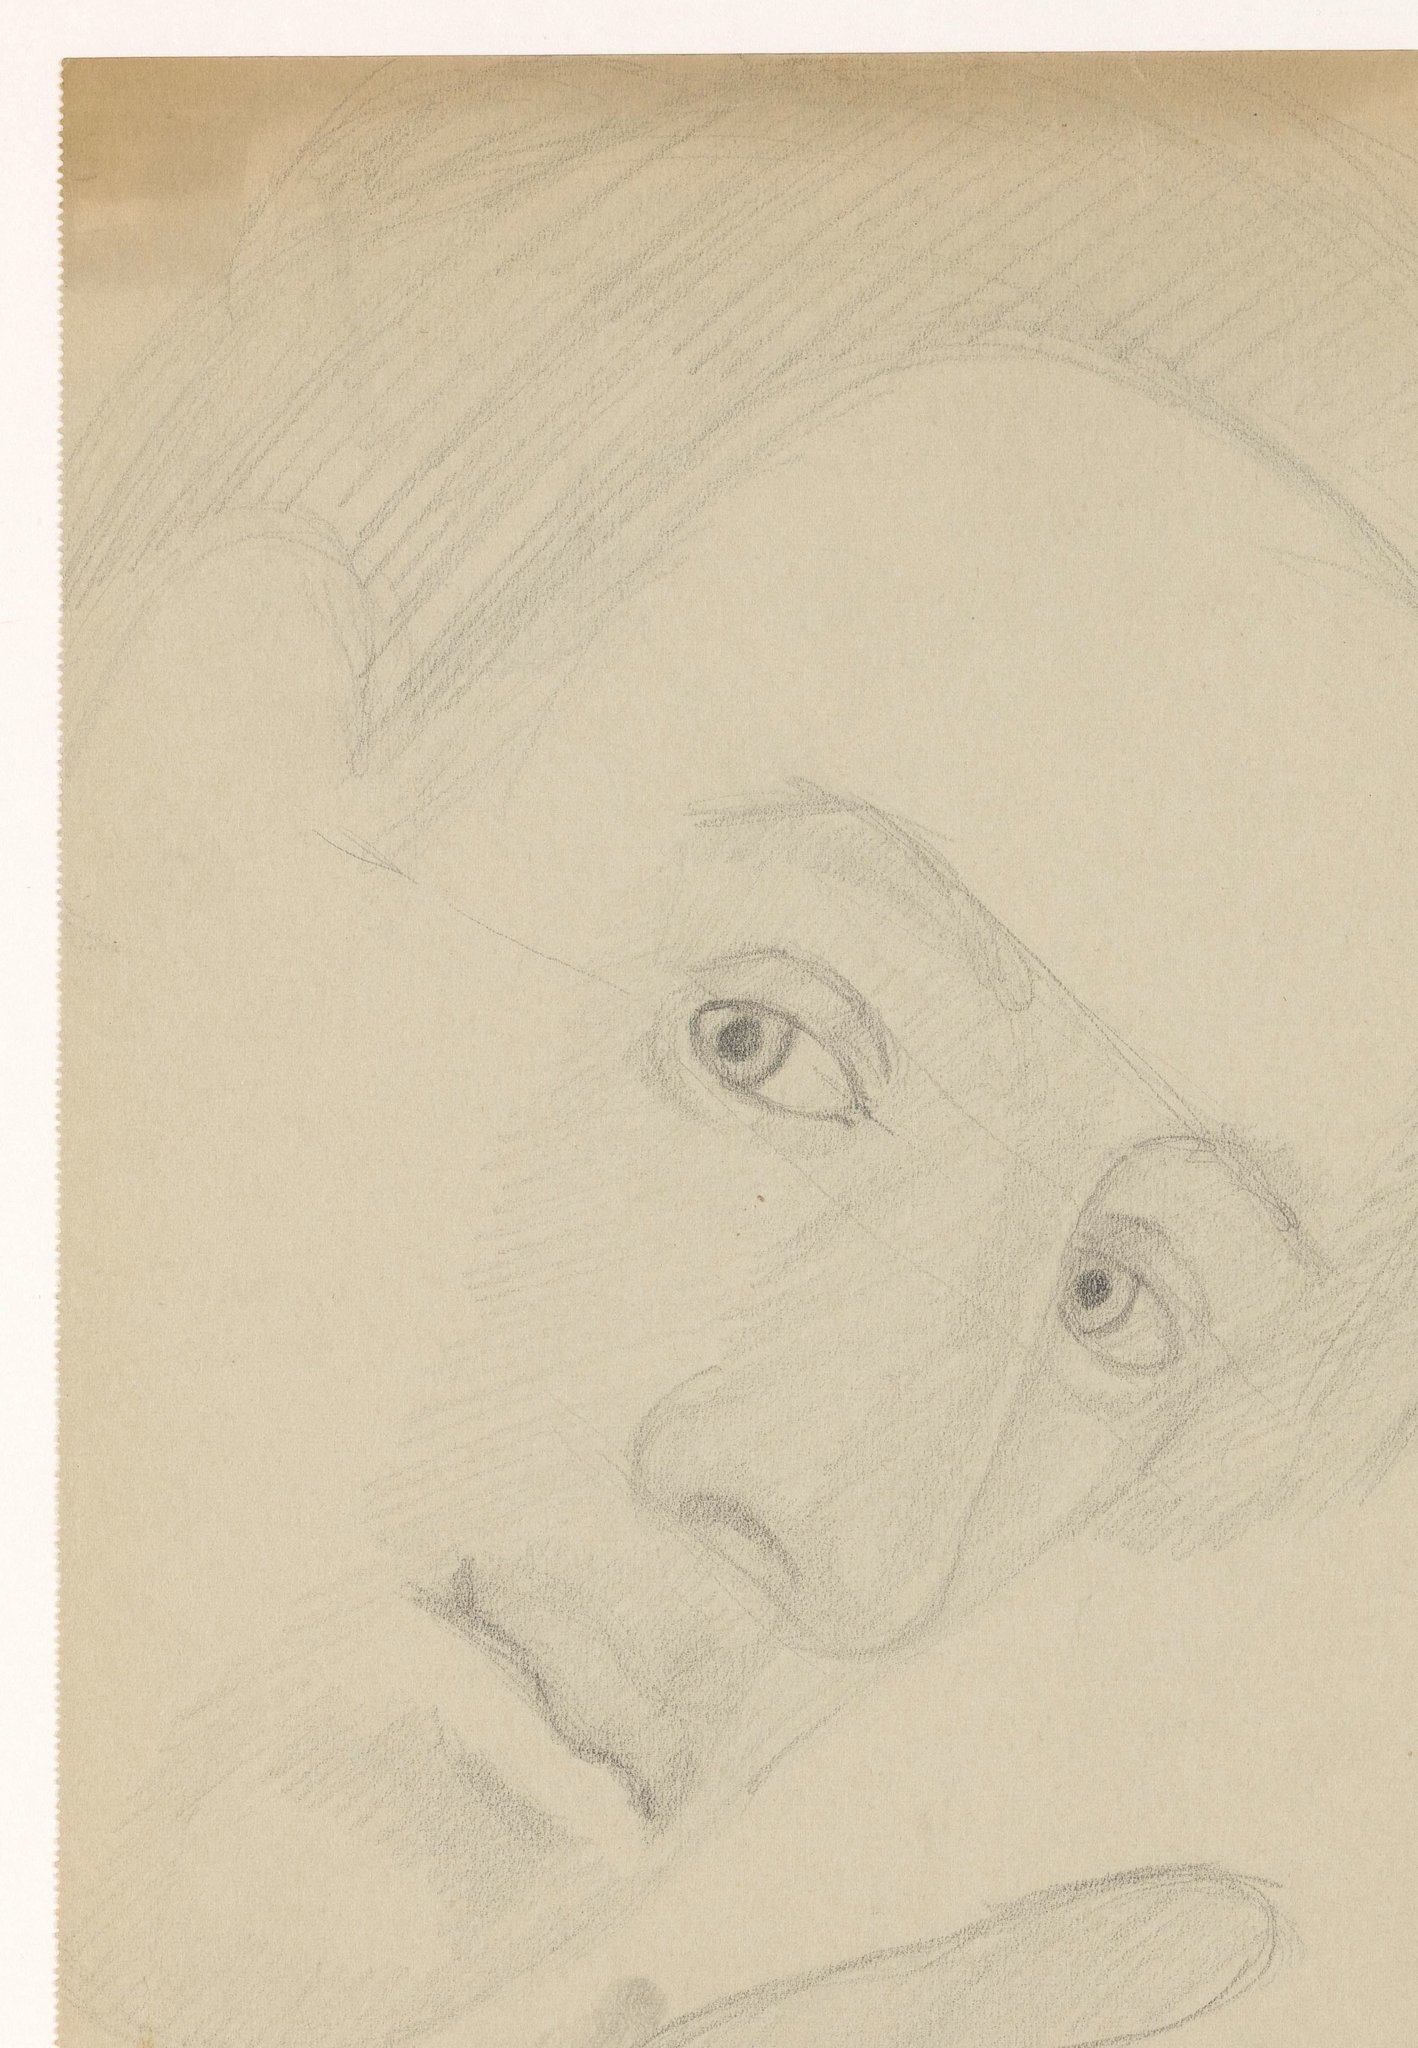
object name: drawing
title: Zelfportret, voorovergebogen met hand op schrift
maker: cor van teeseling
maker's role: draughtsman, sculptor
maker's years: 1915-1942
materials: paper, pencil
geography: amsterdam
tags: amsterdam, draughtsman, sculptor, cor van teeseling, historical persons, prisoner in cell or locked place, portrait, self-portrait of draughtsman, netherlands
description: Zelfportret van voorovergebogen Cor van Teeseling, met hand op schrift.